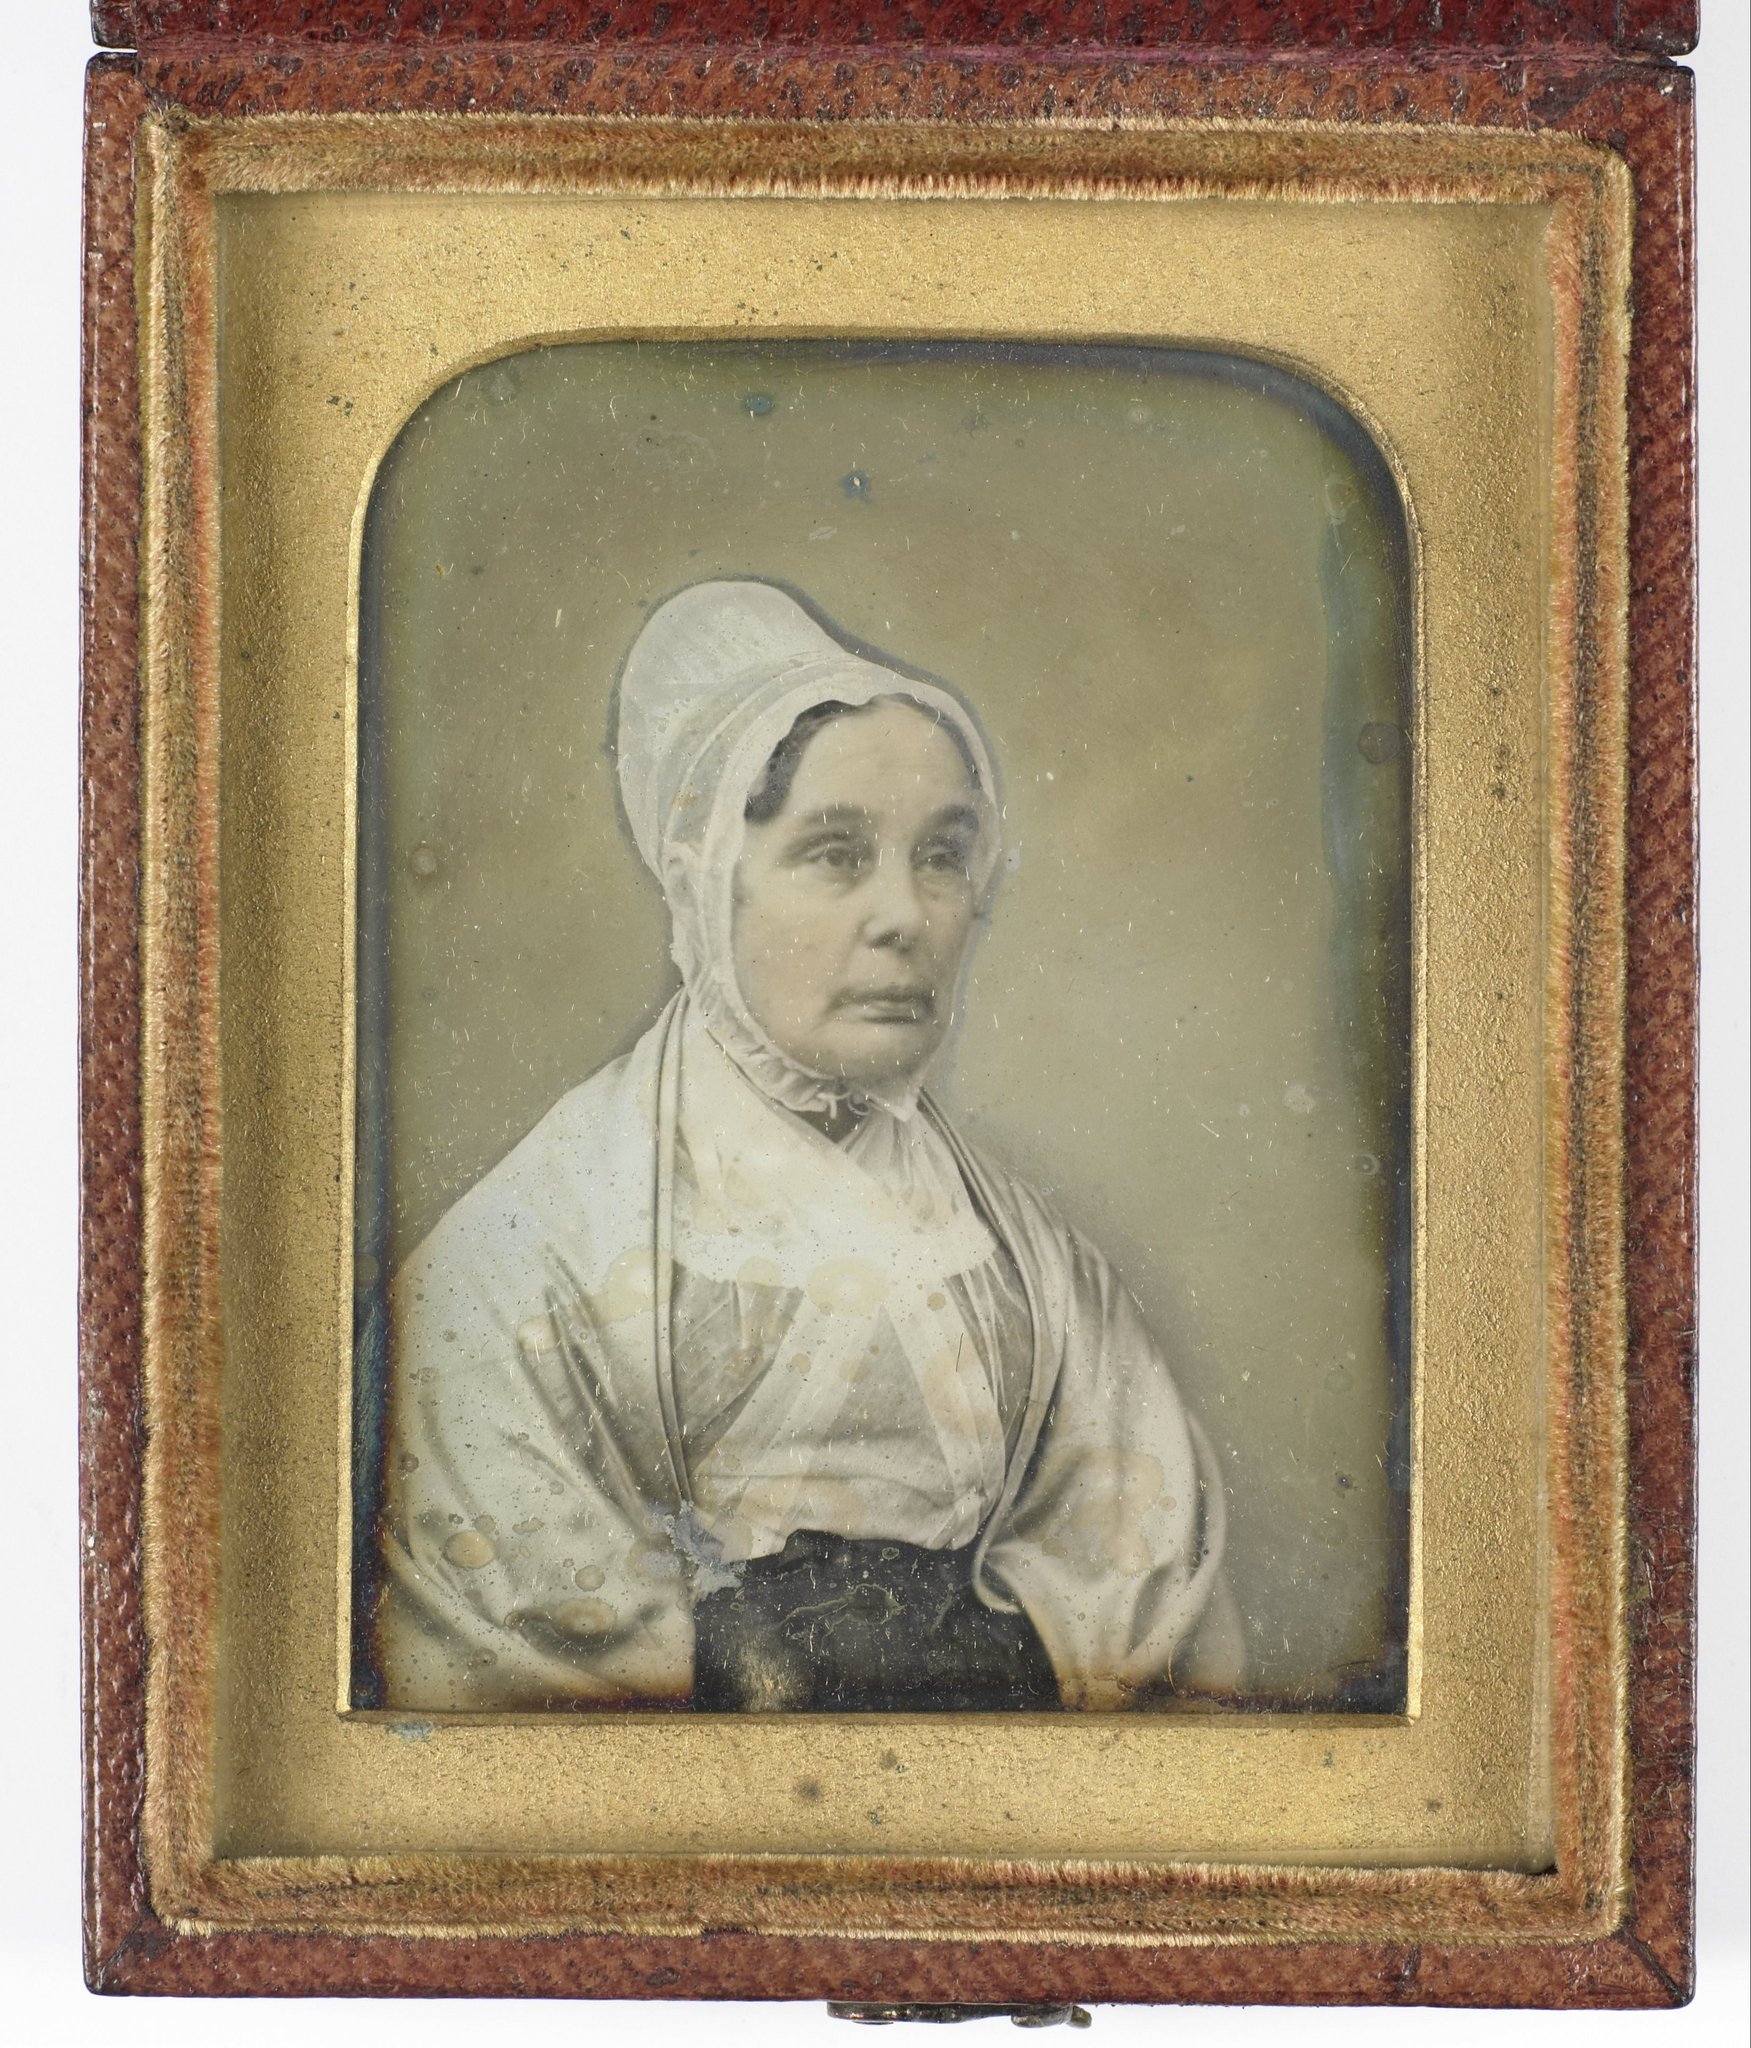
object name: photograph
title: Portret van een onbekende vrouw in klederdracht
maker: Anonymous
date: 1840-1860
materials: copper, glass, leather, velvet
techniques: daguerreotype, hand coloring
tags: adult woman, historical persons